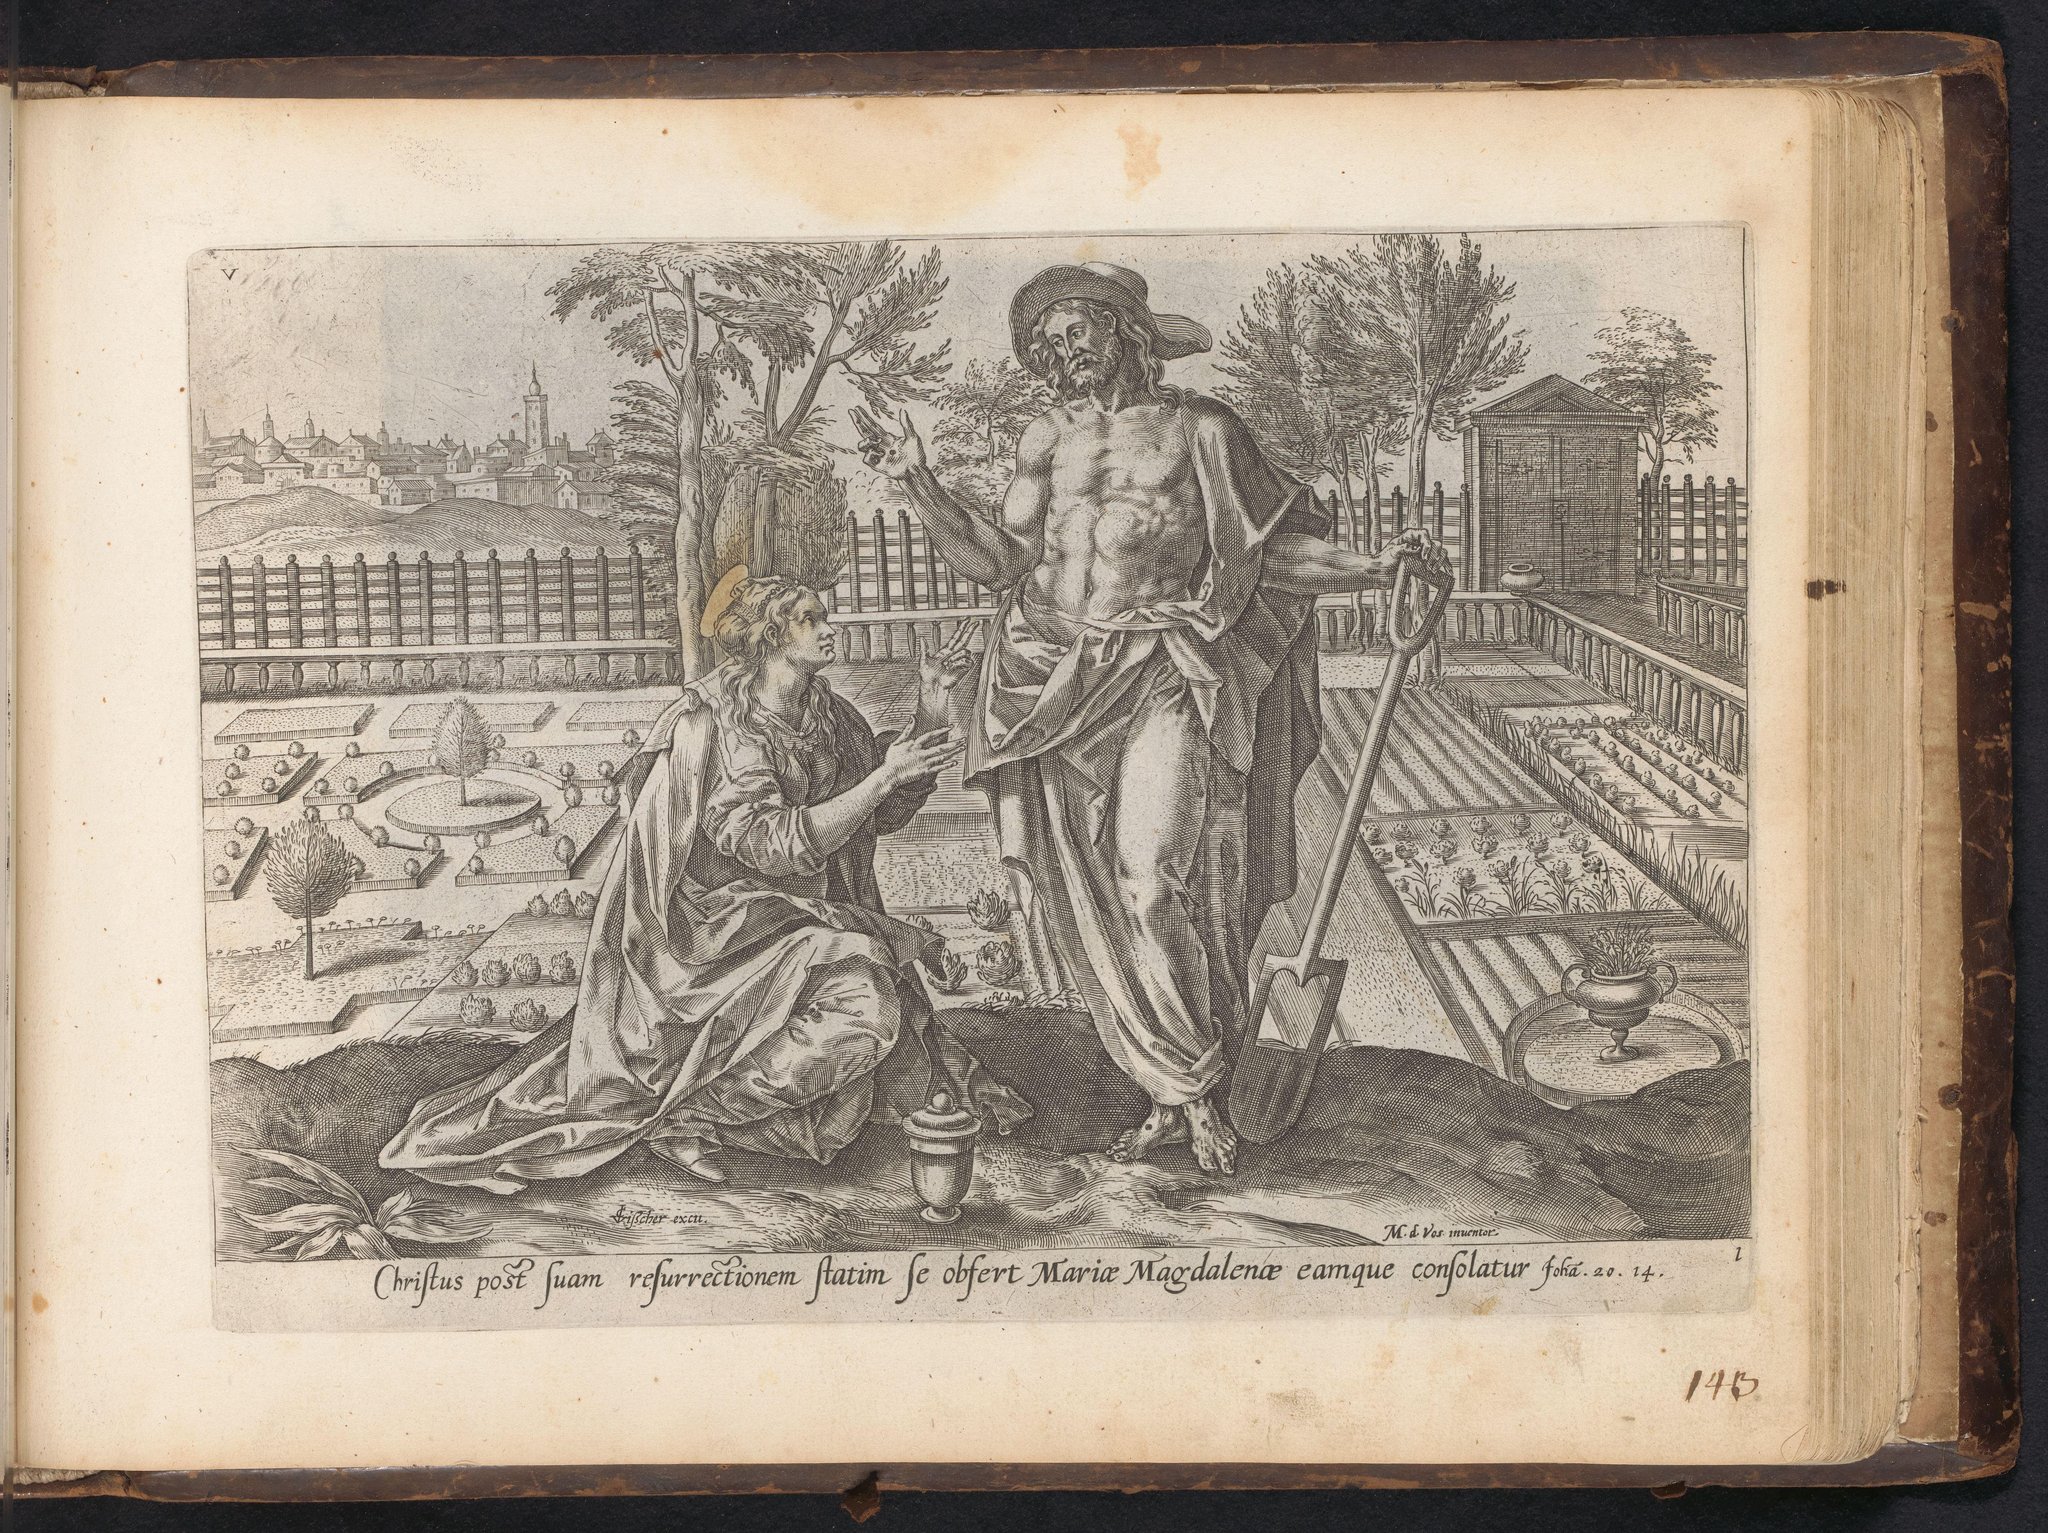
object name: print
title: Christus verschijnt als tuinman aan Maria Magdalena (Noli me tangere)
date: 1585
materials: paper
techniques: engraving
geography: alkmaar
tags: mary magdalene kneeling before christ, who is usually represented as a gardener with a hoe and/or a spade; 'noli me tangere'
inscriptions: number: ‘143’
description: Maria Magdalena herkent de opgestane Christus, nadat ze hem voor tuinman had aangezien, en knielt voor hem. Christus is gekleed als tuinman. Hij zegt haar hem niet vast te houden. Onder de voorstelling een verwijzing in het Latijn naar de Bijbeltekst in Joh. 20:14. Deze prent maakt deel uit van een album.